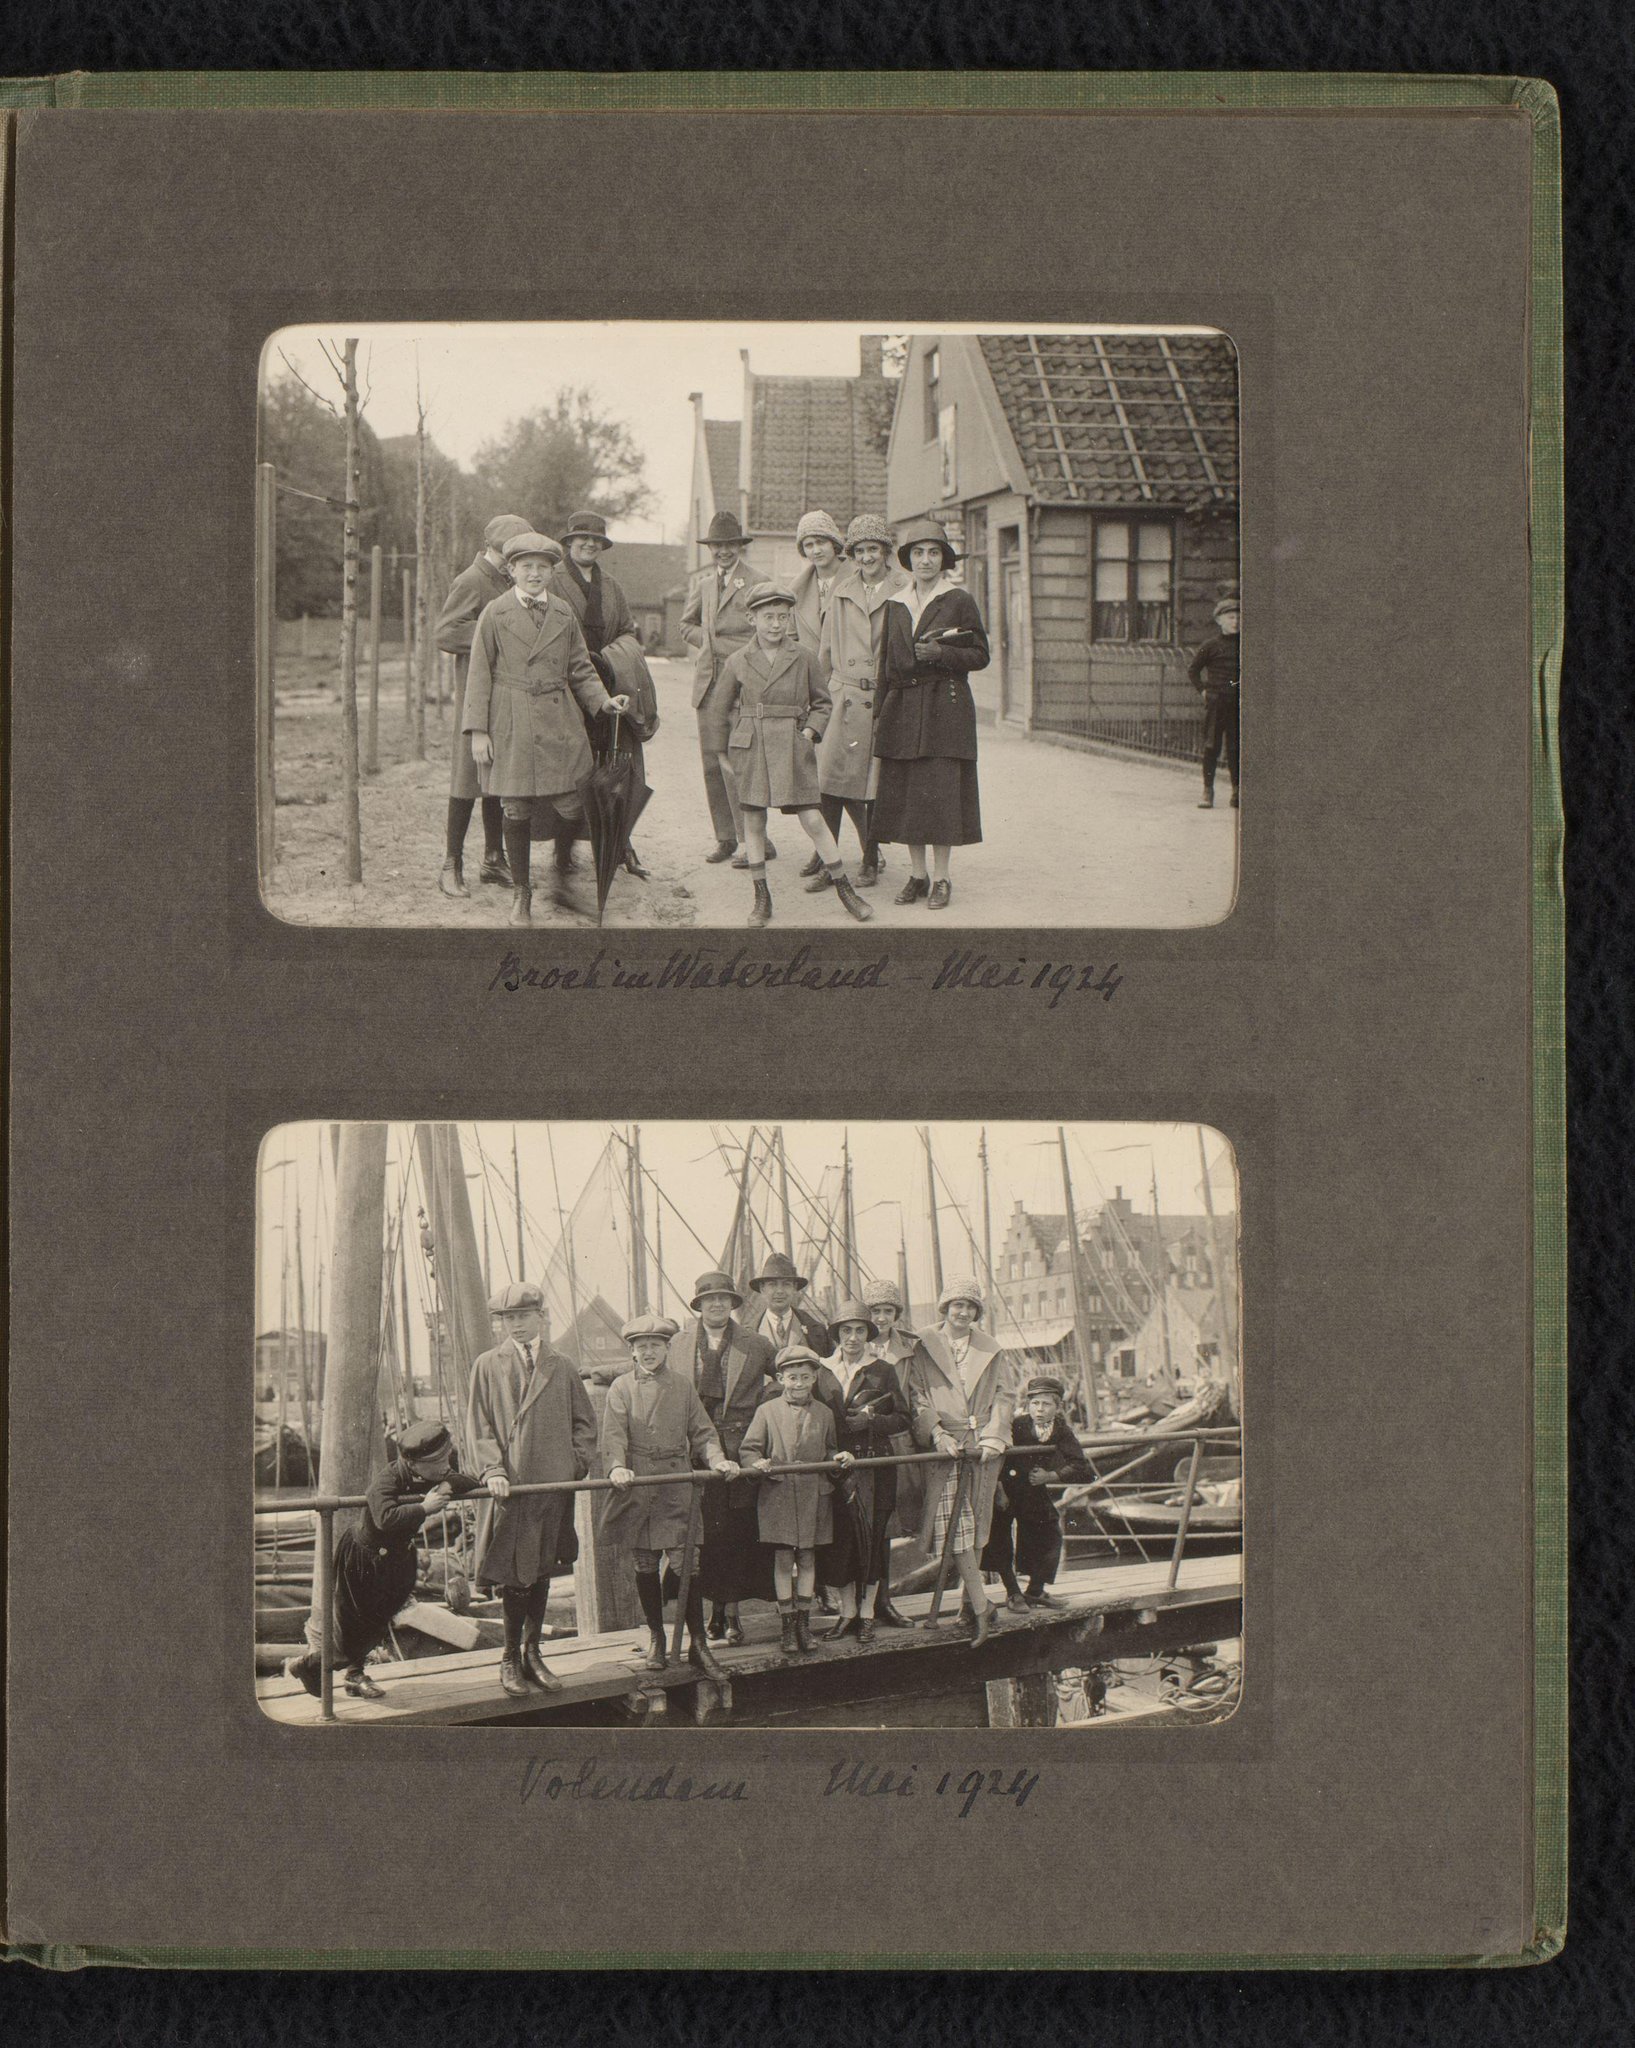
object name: album leaf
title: Twee foto's van de familie Van den Berg in Broek in Waterland en Volendam, mei 1924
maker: hendrik herman van den berg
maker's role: amateurfotograaf, jurist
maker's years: 1875-1944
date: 1905-1924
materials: paper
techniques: gelatin silver print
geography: north holland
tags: family group, especially parents with their child(ren)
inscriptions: inscription: ‘Broek in Waterland - Mei 1924’, inscription: ‘Volendam - Mei 1924’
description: Deze foto's maken deel uit van een album.